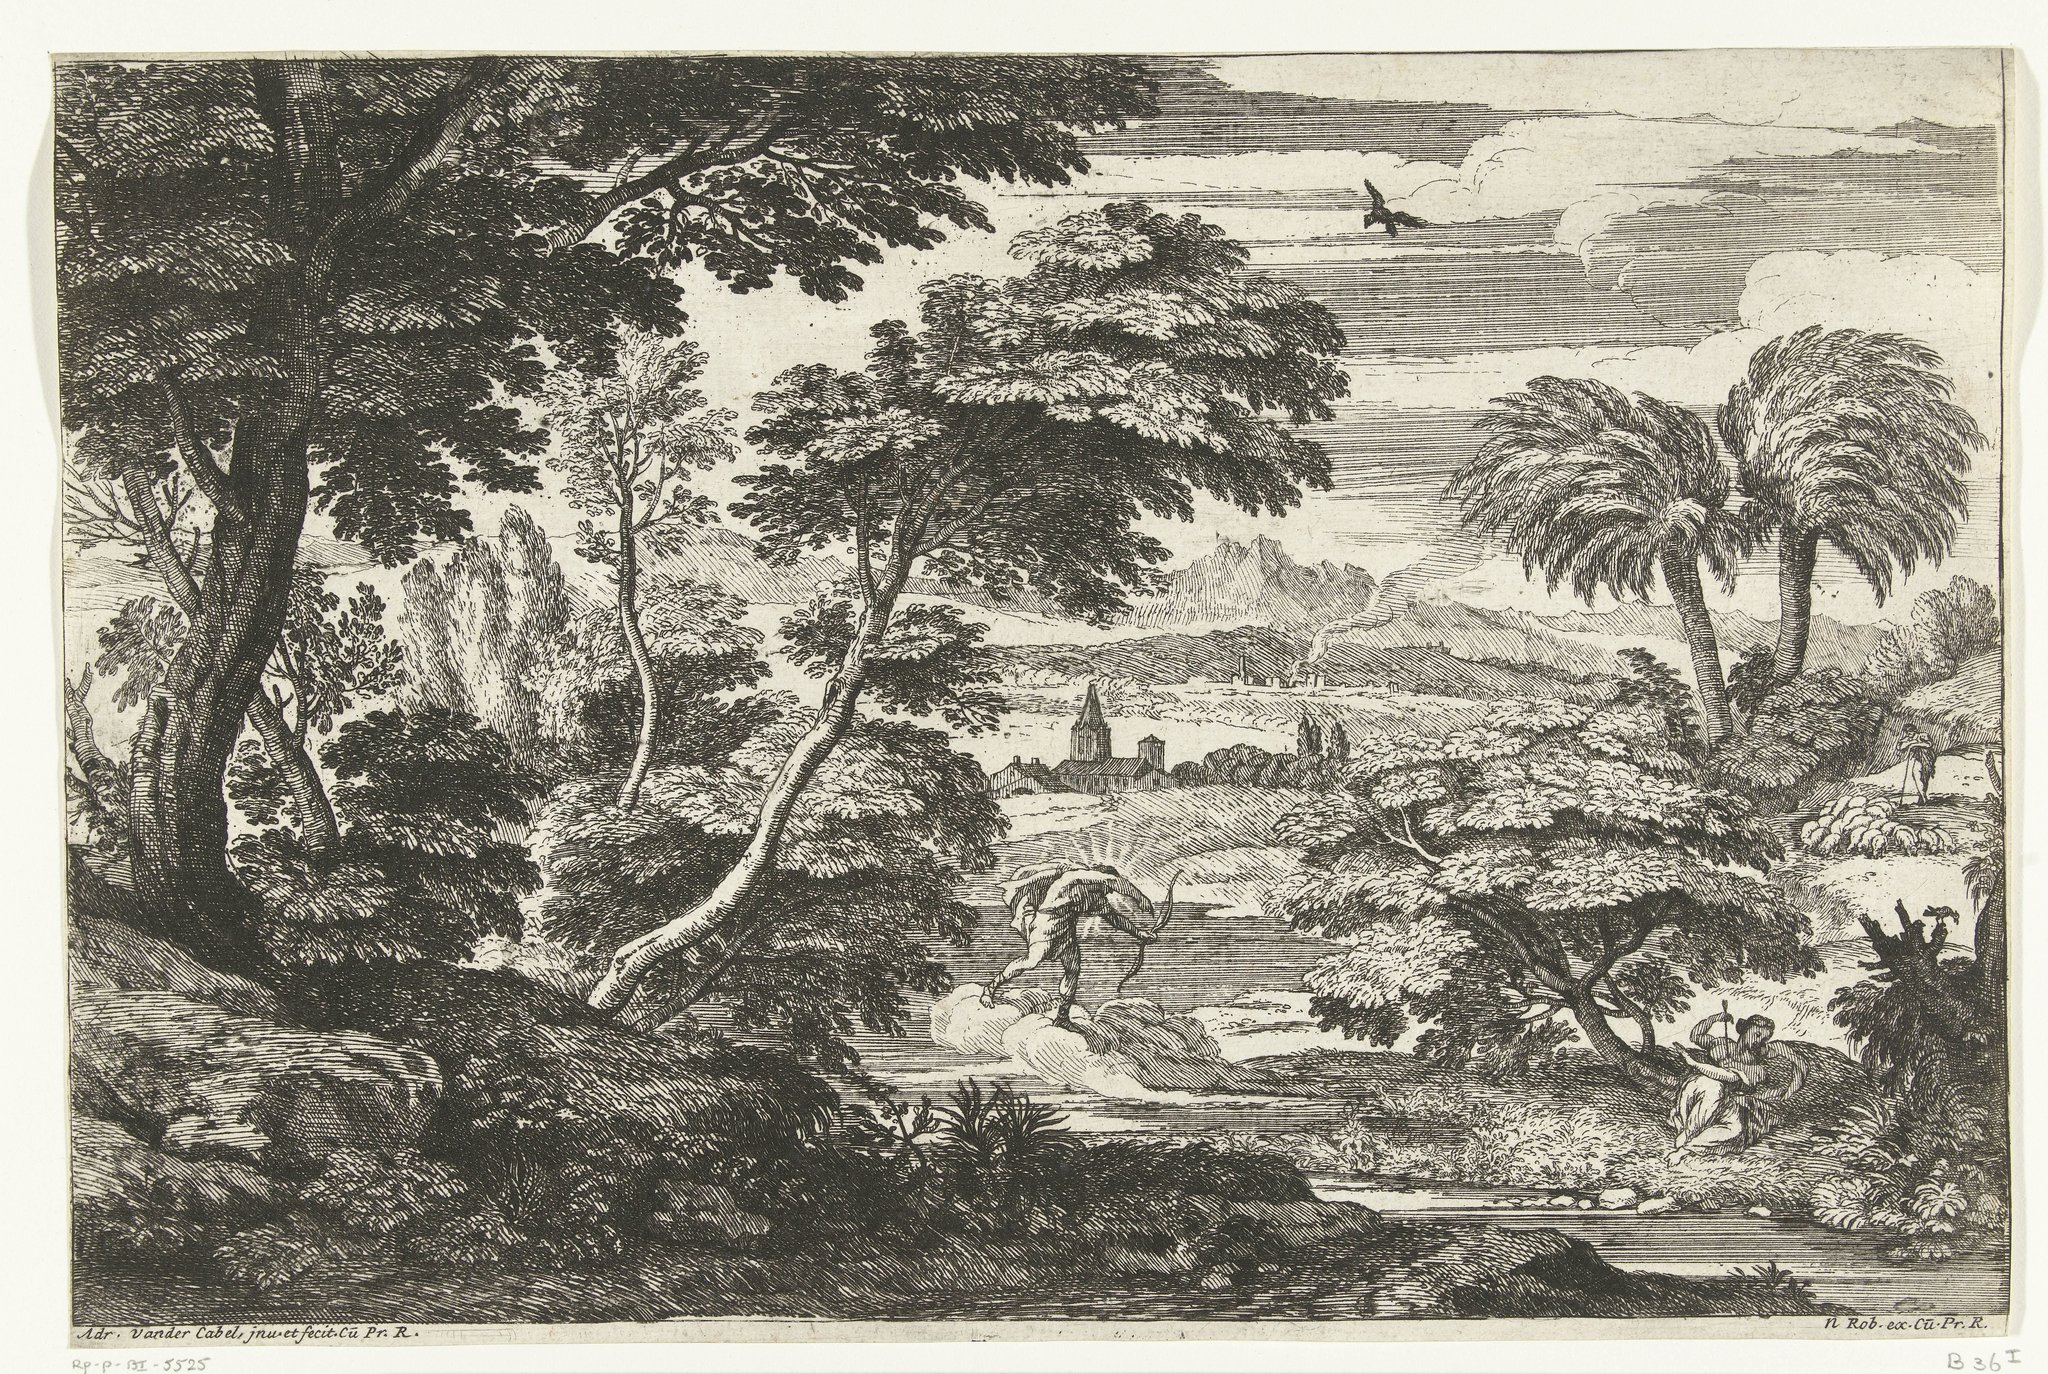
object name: print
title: Apollo doodt Coronis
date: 1648-1705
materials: paper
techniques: etching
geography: france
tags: landscapes, apollo shoots coronis, but repenting his act he tries in vain to recall her to life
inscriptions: collector's mark: Lugt 240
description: Landschap met hoge bomen op de voorgrond en gezicht op man met boog, staand op wolk en vrouw met pijl in de borst, zittend onder lage boom, aan waterkant. Op de achtergrond een dorp. Vijfde prent uit de serie van zes.